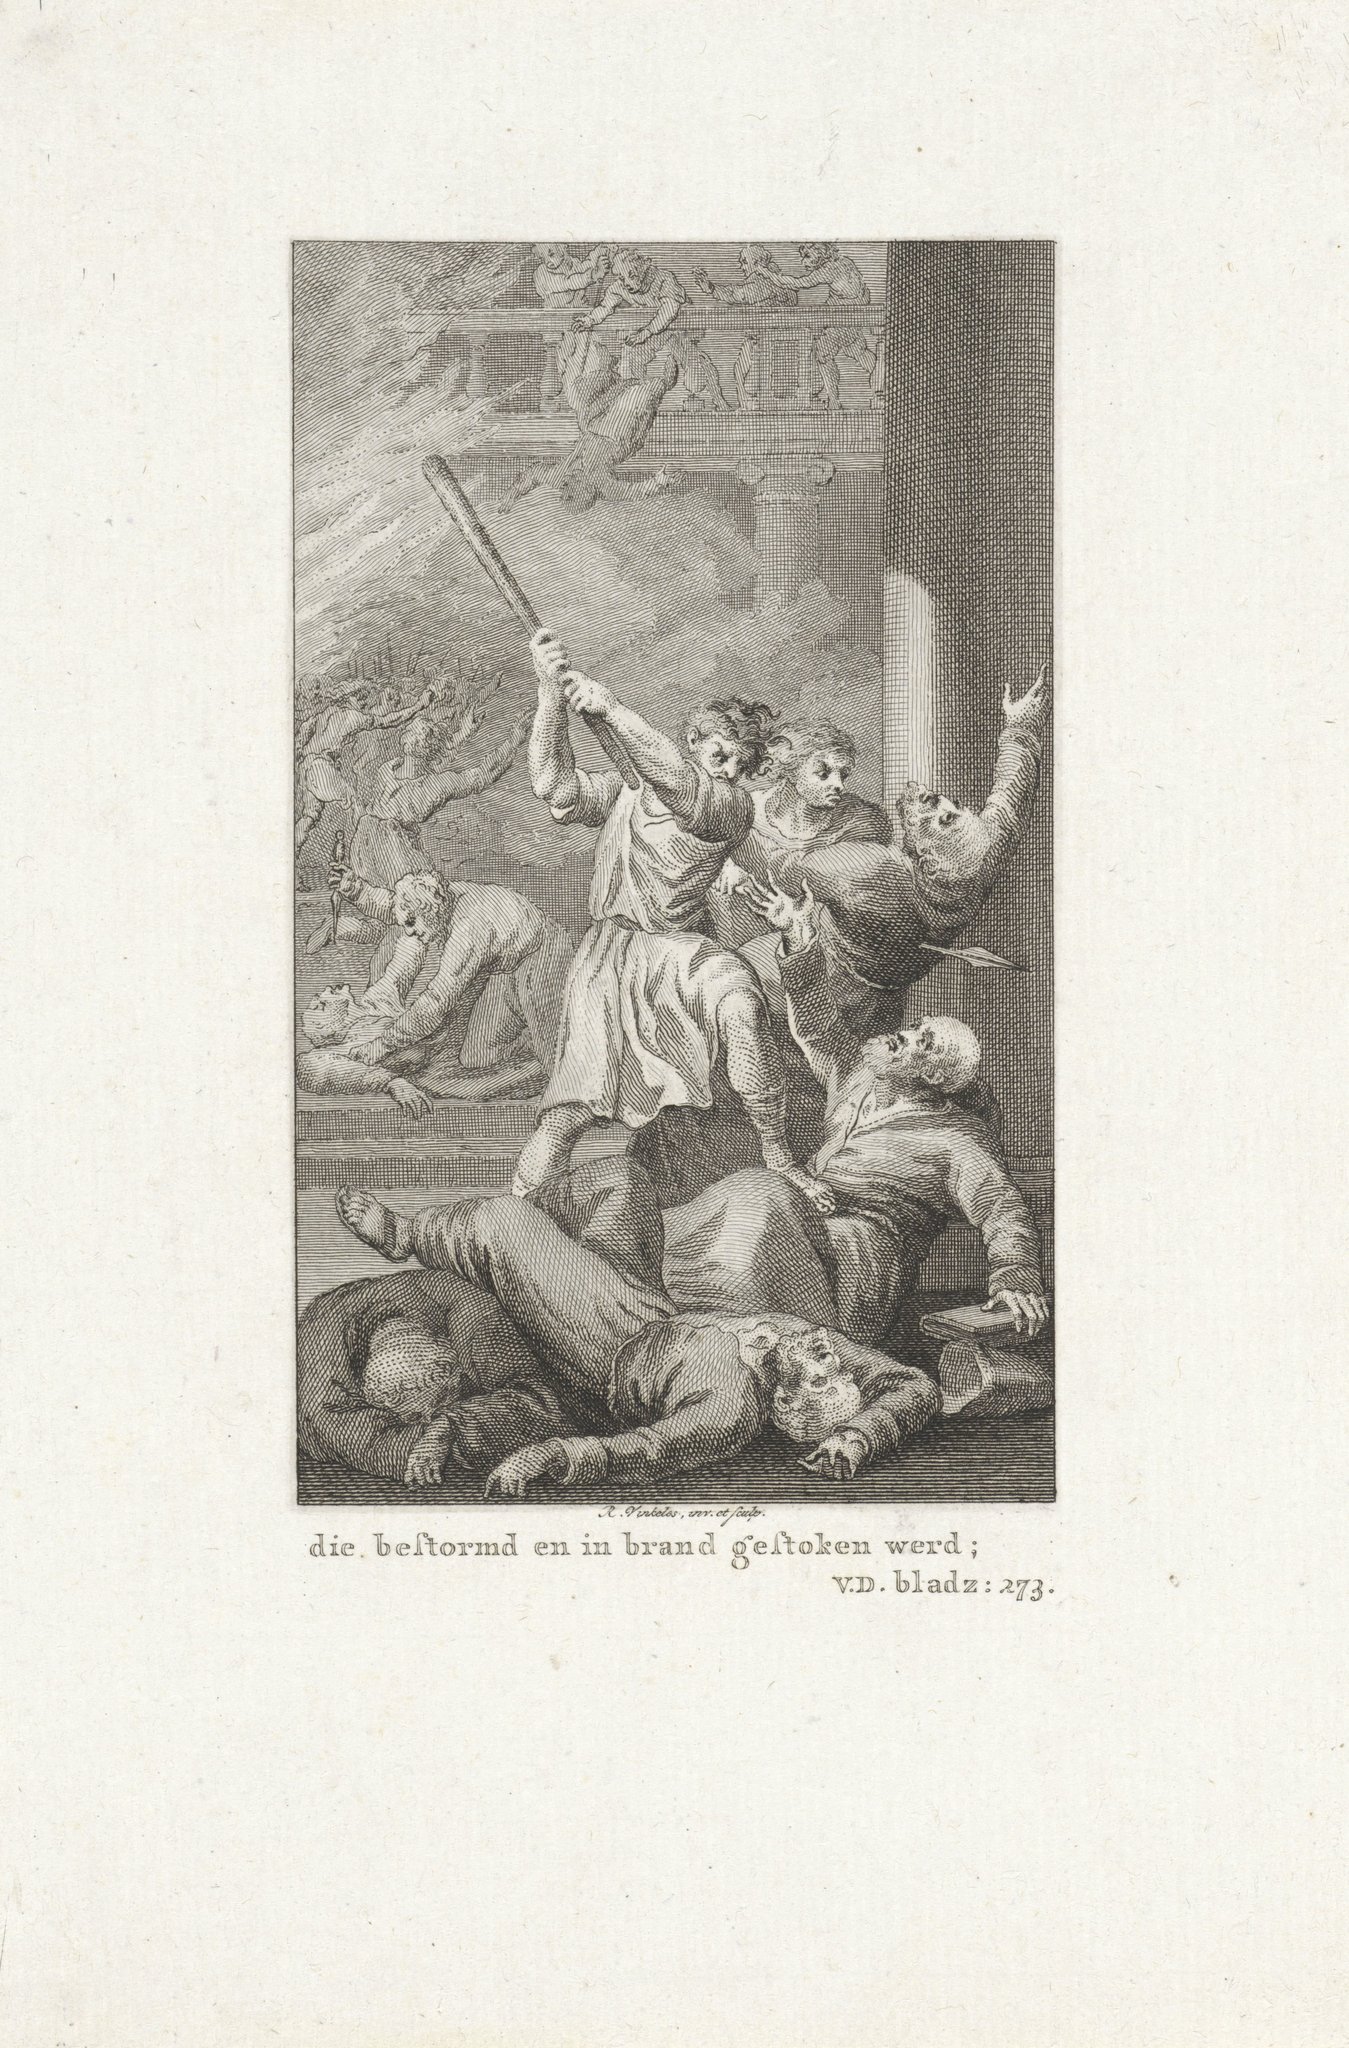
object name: print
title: Aanhangers van Damasus bestormen een kerk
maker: reinier vinkeles (i)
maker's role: draughtsman, print maker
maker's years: 1741-1816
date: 1802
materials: paper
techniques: engraving, etching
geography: amsterdam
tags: on fire, ablaze, interior of church, (military) attack, violent death, being killed; being mishandled and maltreated; seeking death - ee - death not certain; wounded person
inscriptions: collector's mark: Lugt 240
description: De aanhangers van Damasus bestormen een kerk in Rome en steken deze in brand. De geestelijken, aanhangers van Ursicinus, die zich in de kerk hebben verschranst worden met stokken, zwaarden en pijlen belaagd.